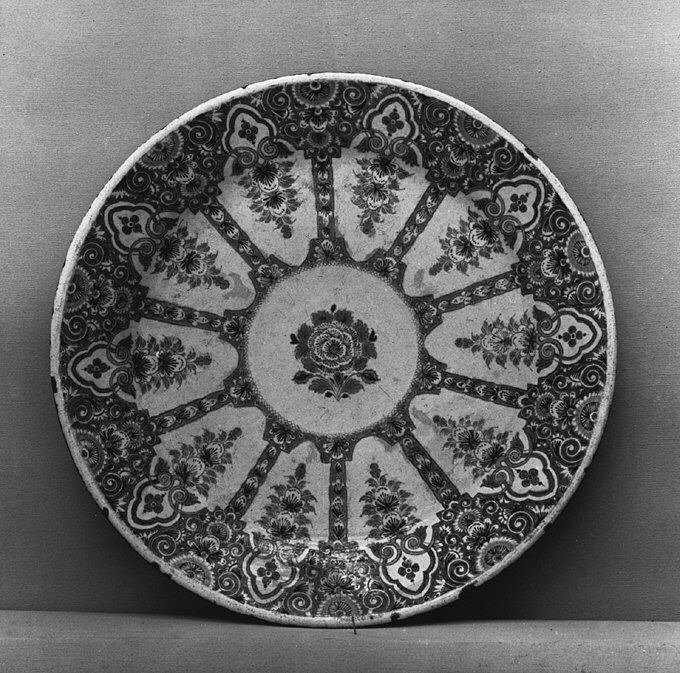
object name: tray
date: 1705-1720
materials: faience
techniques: glazing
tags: flowers